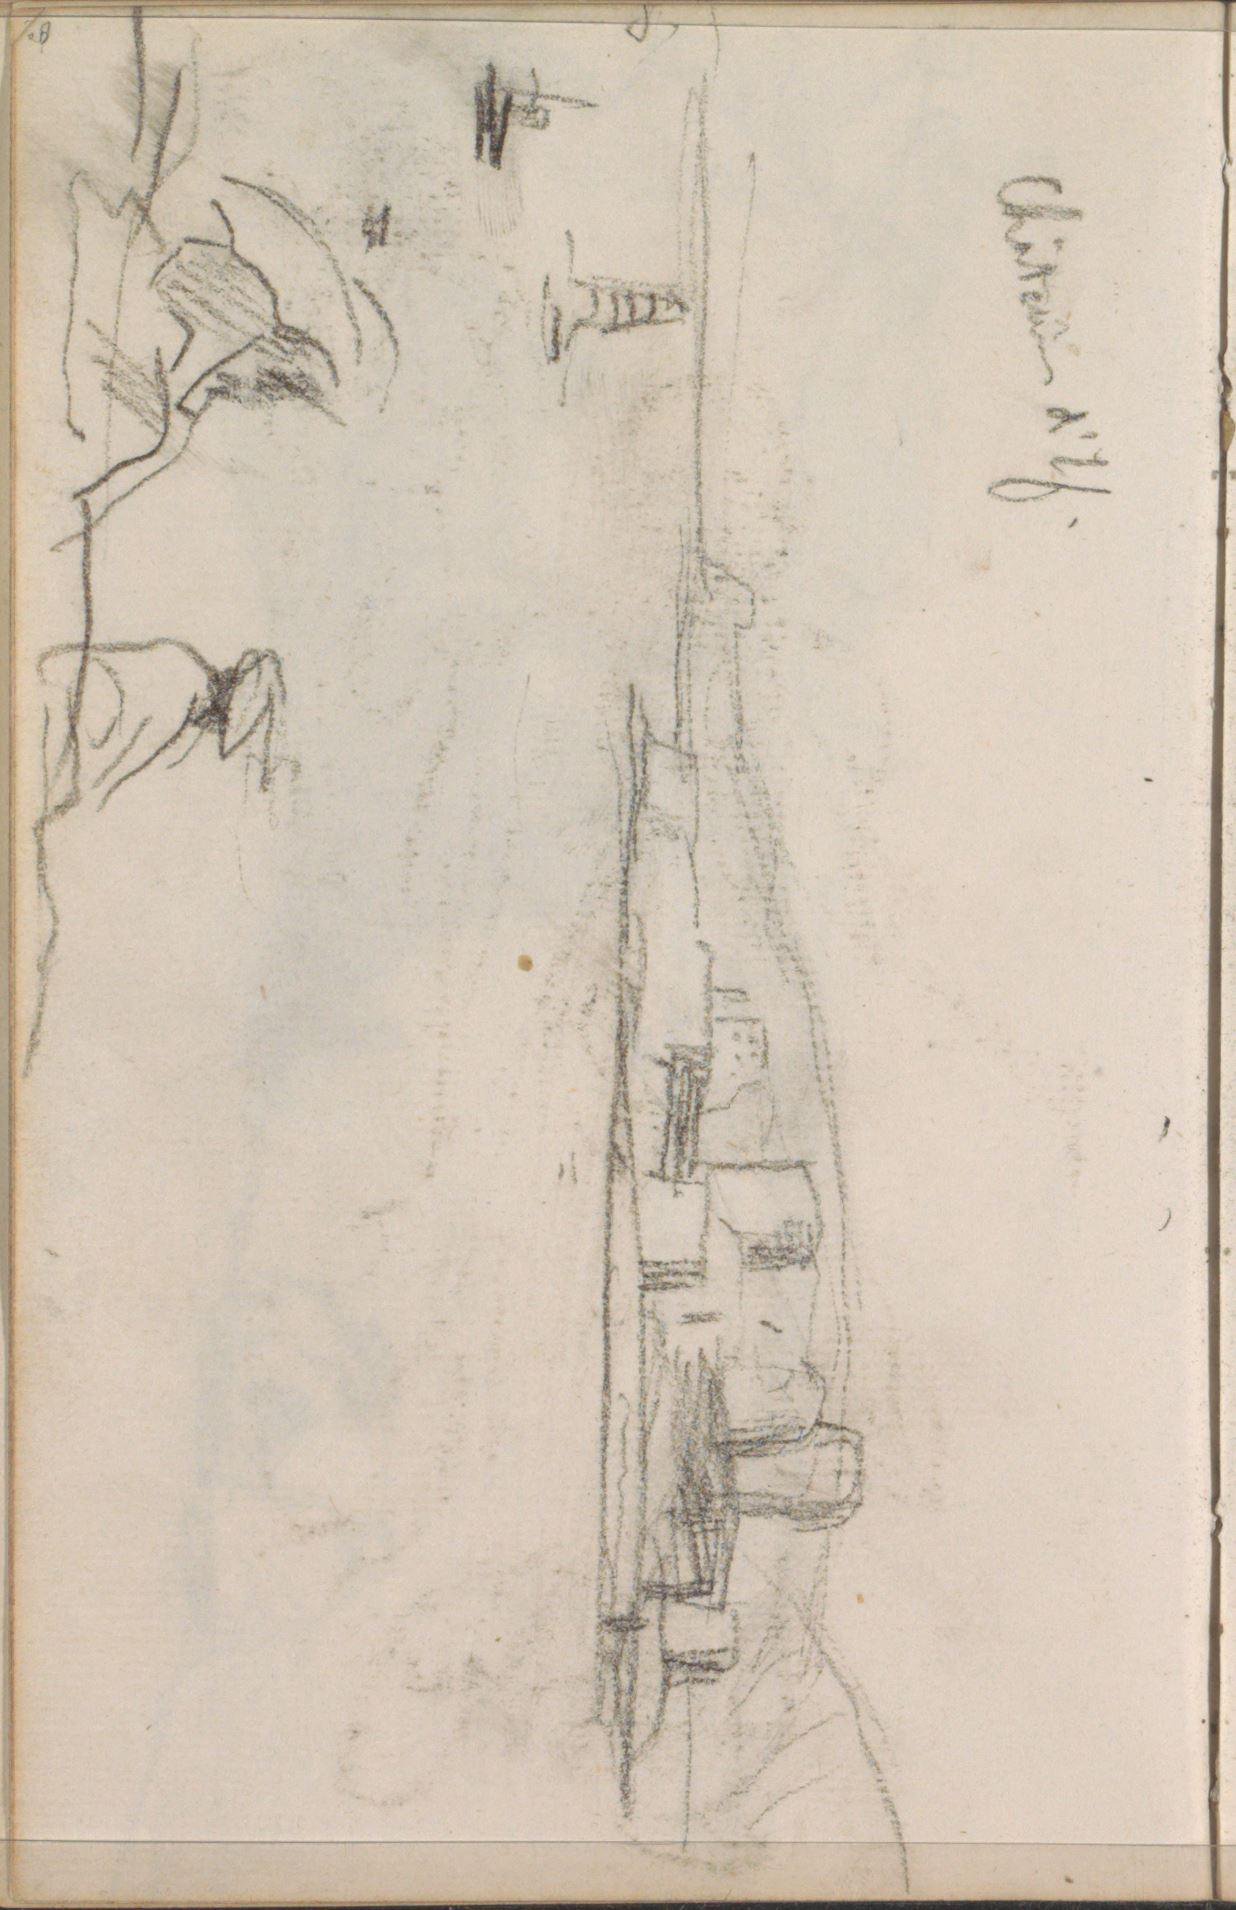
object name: sketchbook leaf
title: Figuren uitkijkend over Château d'If bij Marseille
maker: marius bauer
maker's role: draughtsman, print maker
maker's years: 1867-1932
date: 1899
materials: chalk, paper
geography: marseille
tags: fortress, city-view, and landscape with man-made constructions, sitting figure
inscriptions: annotation: ‘Château d'If.’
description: Pagina 28 uit een schetsboek met 42 bladen.